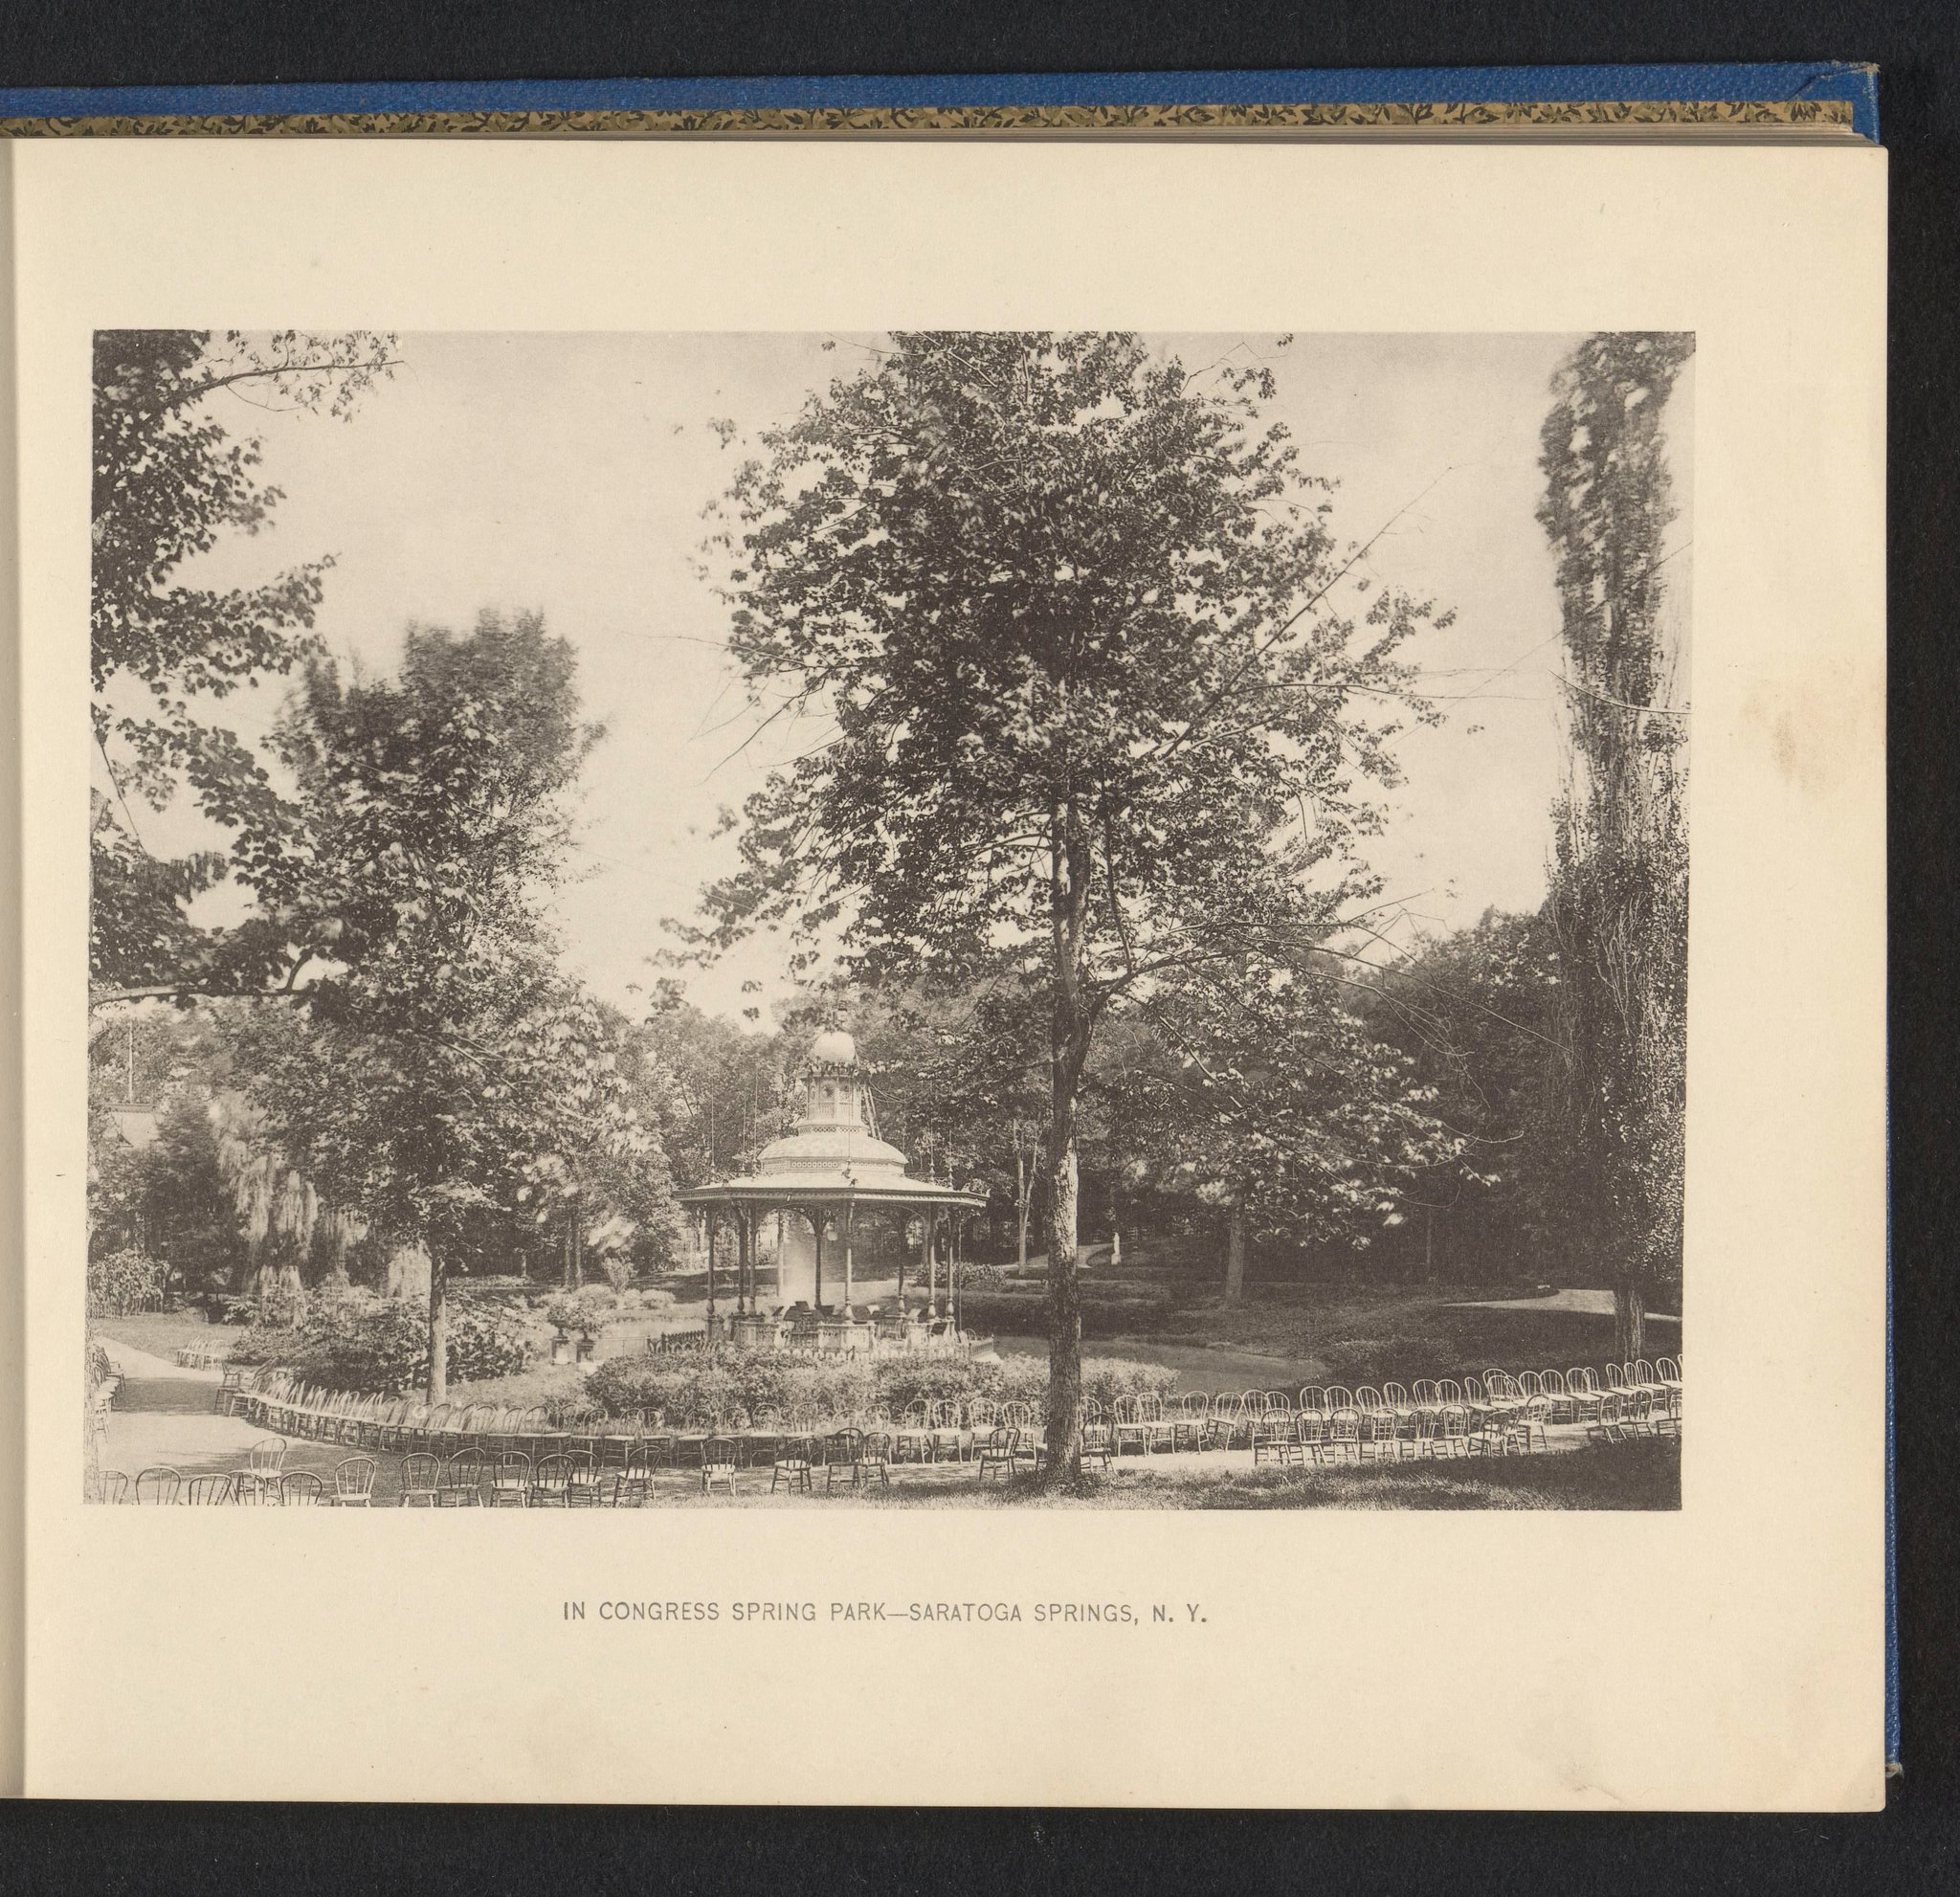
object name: page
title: In Congress Spring Park - Saratoga Springs, N.Y.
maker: Anonymous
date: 1883-1893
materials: paper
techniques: photograph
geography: saratoga springs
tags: public gardens, park